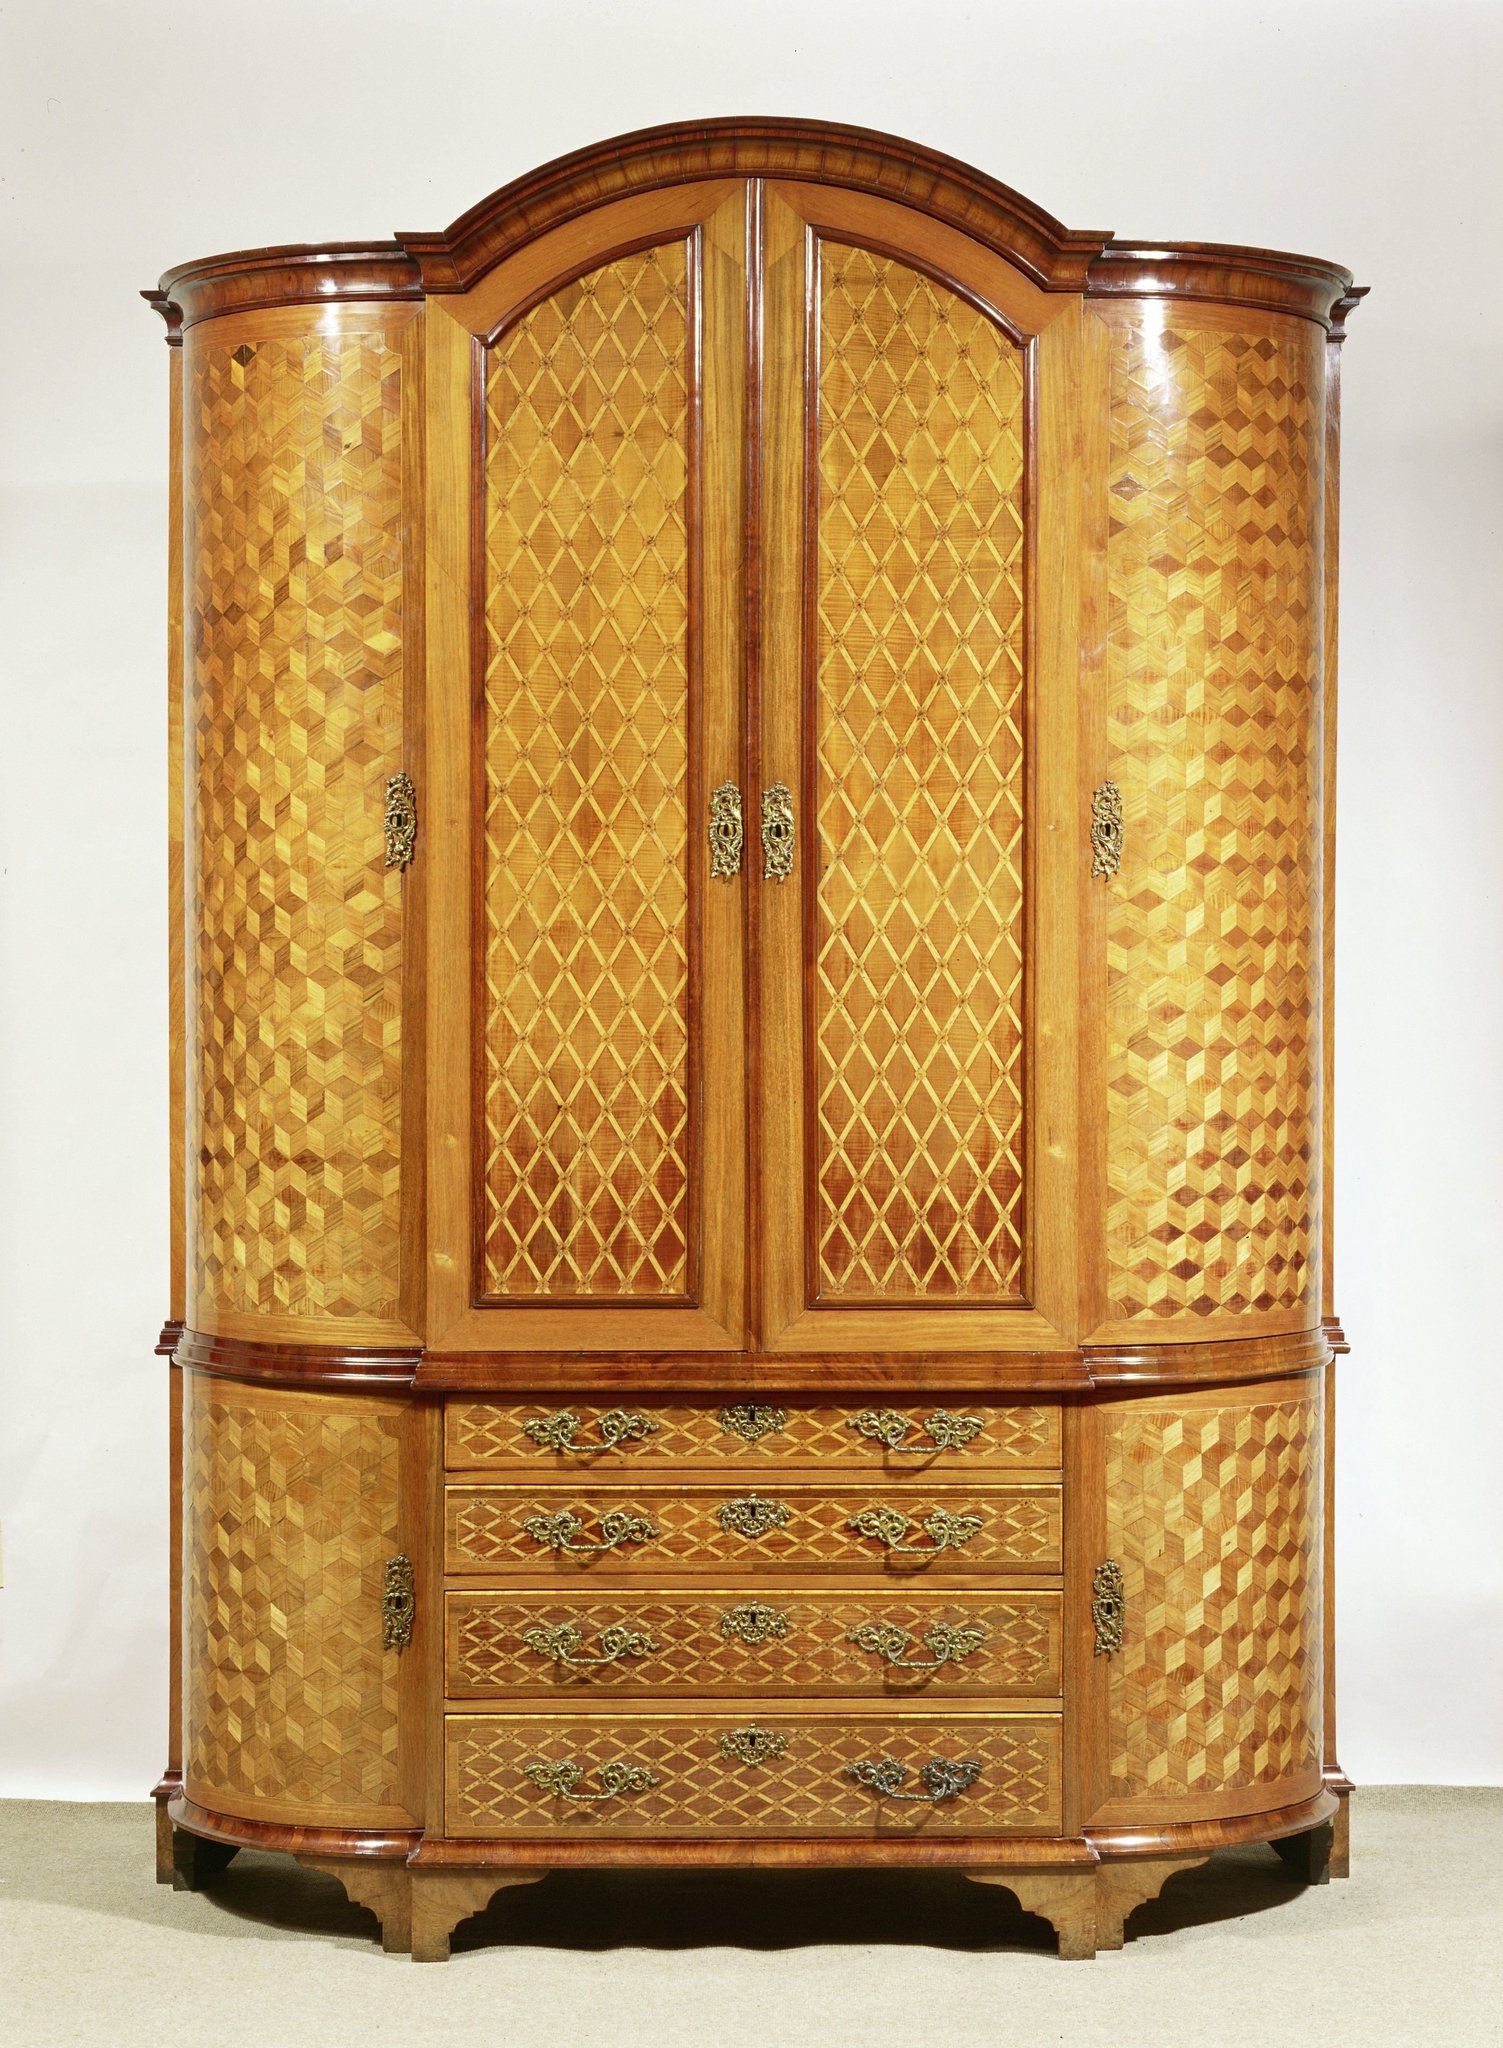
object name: case furniture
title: Kast met rechthoekig naar voren springend middengedeelte, geflankeerd door twee kwartronde gedeeltes. Eikenhout, belijmd met diverse soorten fineer en met beslag van koper.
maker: Anonymous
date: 1765-1780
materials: copper, wood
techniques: veneer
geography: netherlands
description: Cupboard. Oak and pine, veneered with mahogany, tulipwood, rosewood, sycamore, walnut and purplewood, brass mounts. Netherlands, c. 1770. S.J. Fontein bequest, 1995.